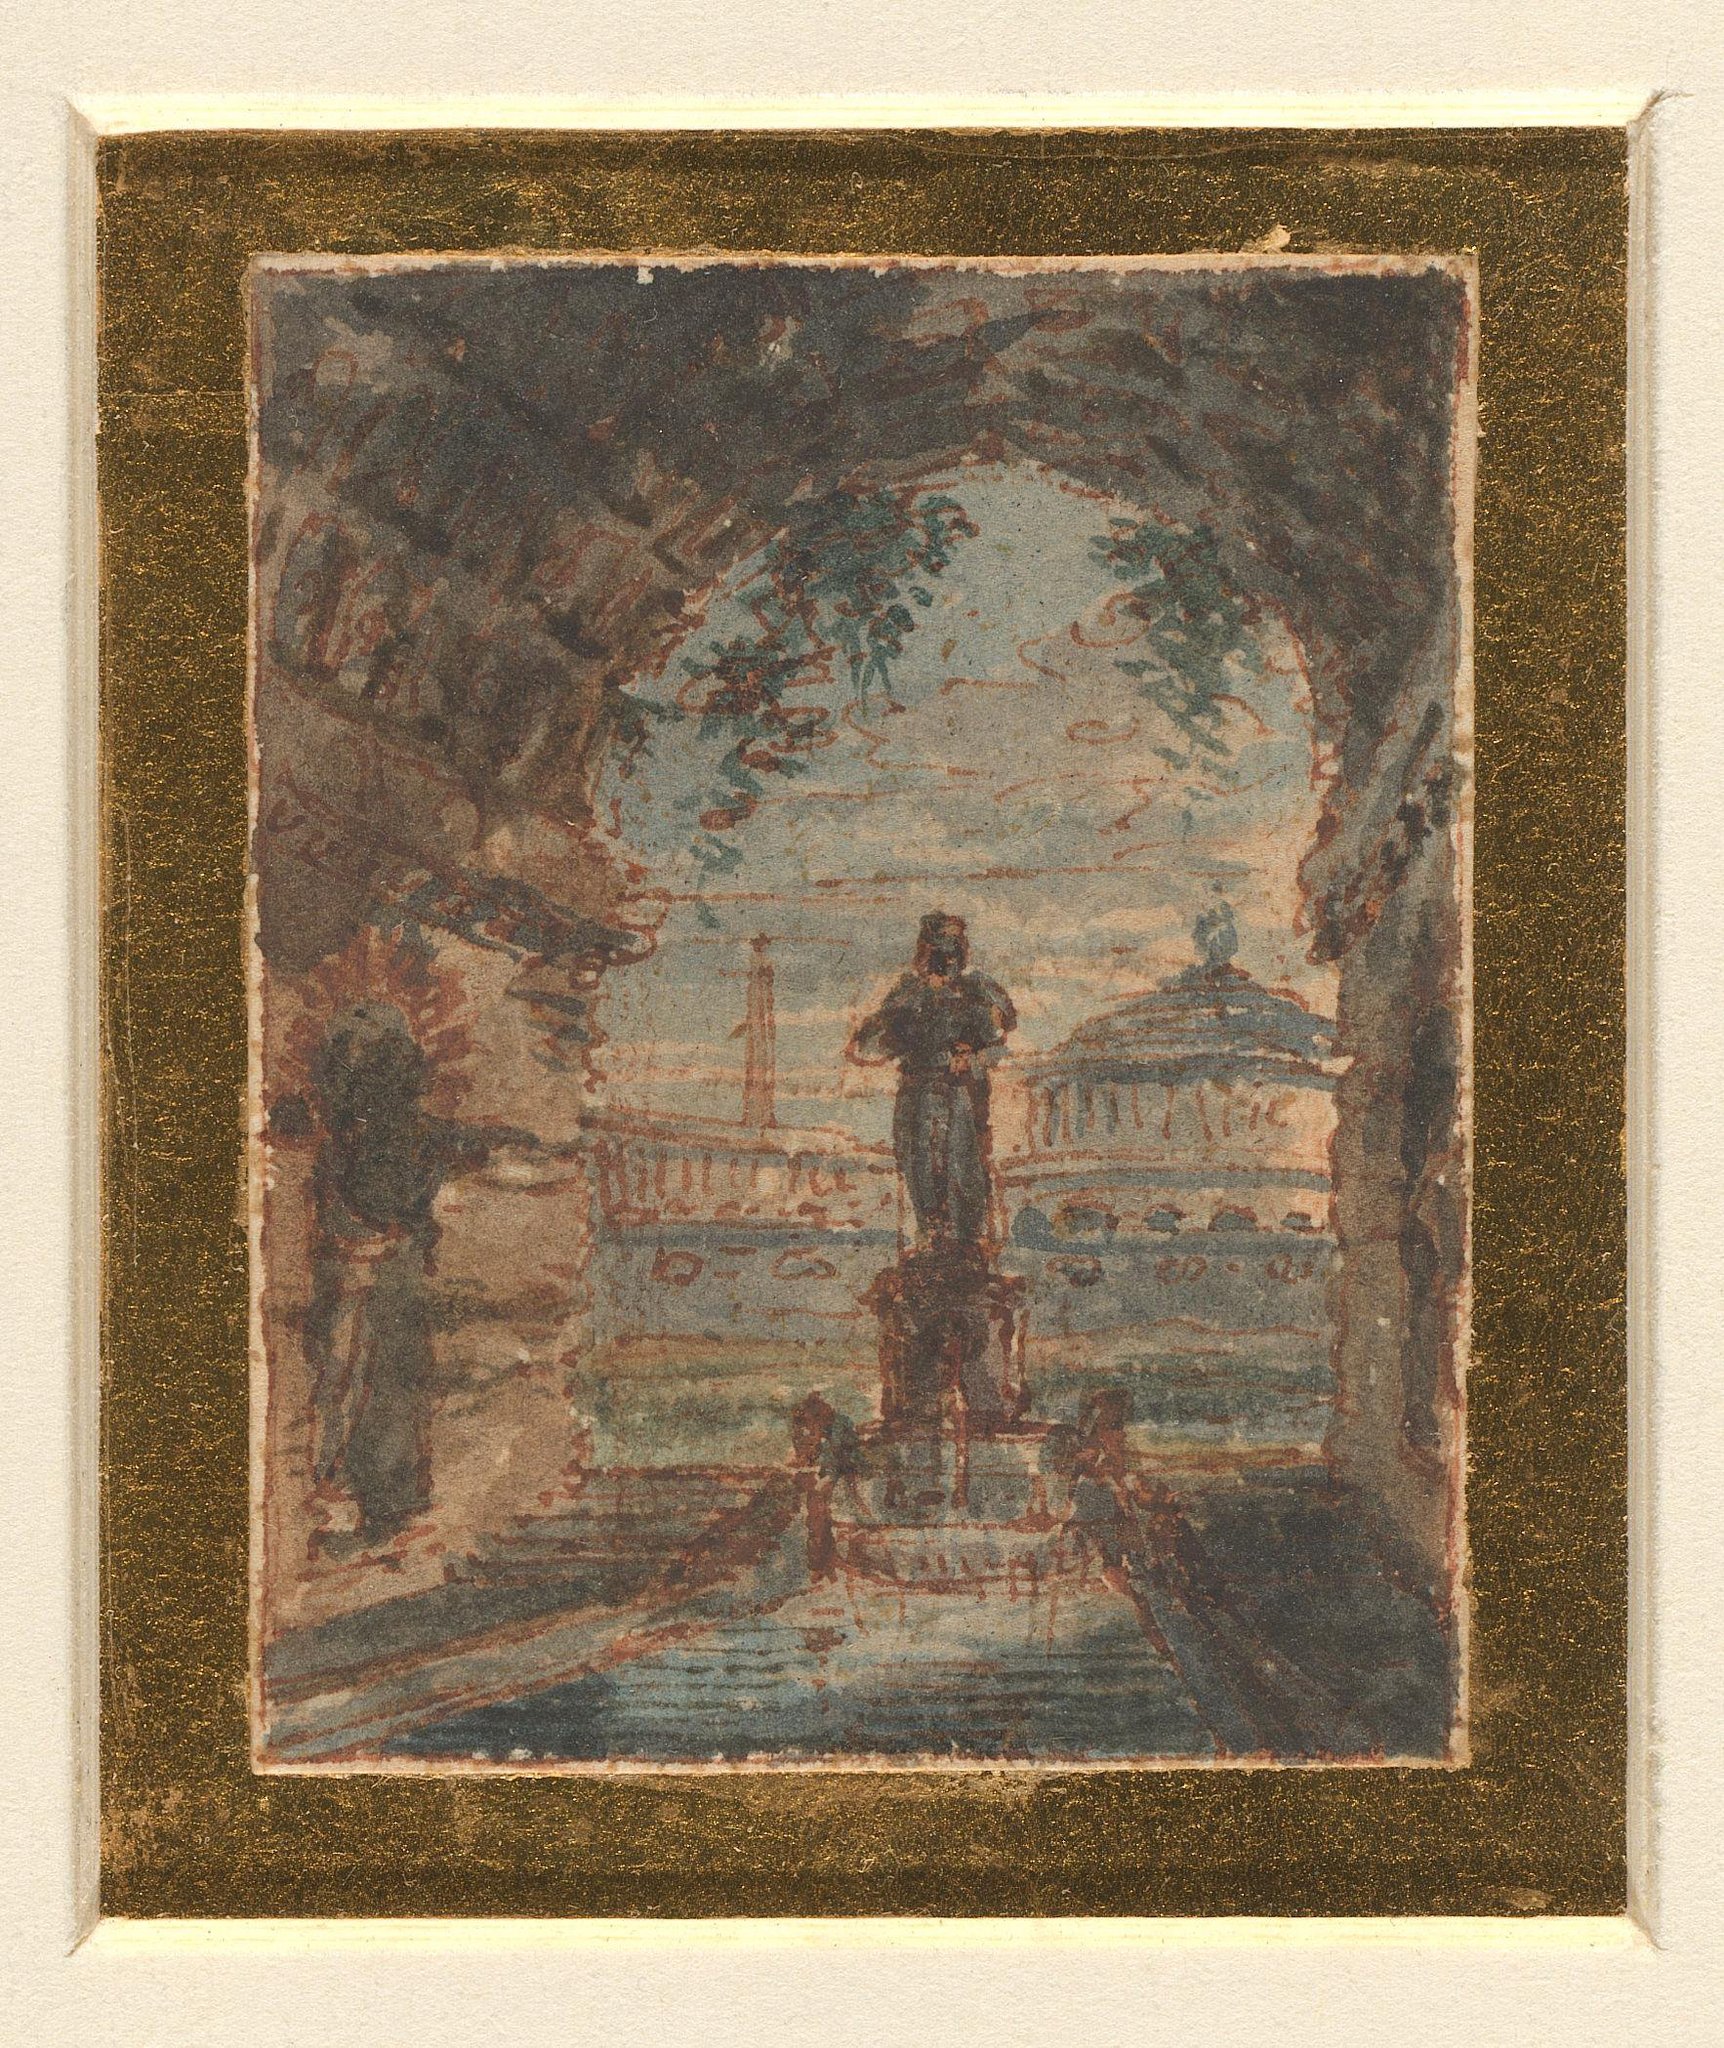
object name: drawing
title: Doorkijk vanuit een rond gewelf op klassieke gebouwen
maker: victor jean nicolle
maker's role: draughtsman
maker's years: 1754-1826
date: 1787-1811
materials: ink, paper, watercolor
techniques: brush, pen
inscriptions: collector's mark: Lugt 2760, collector's mark: Lugt 2228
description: Ten midden van het geweld staat een klassiek standbeeld.